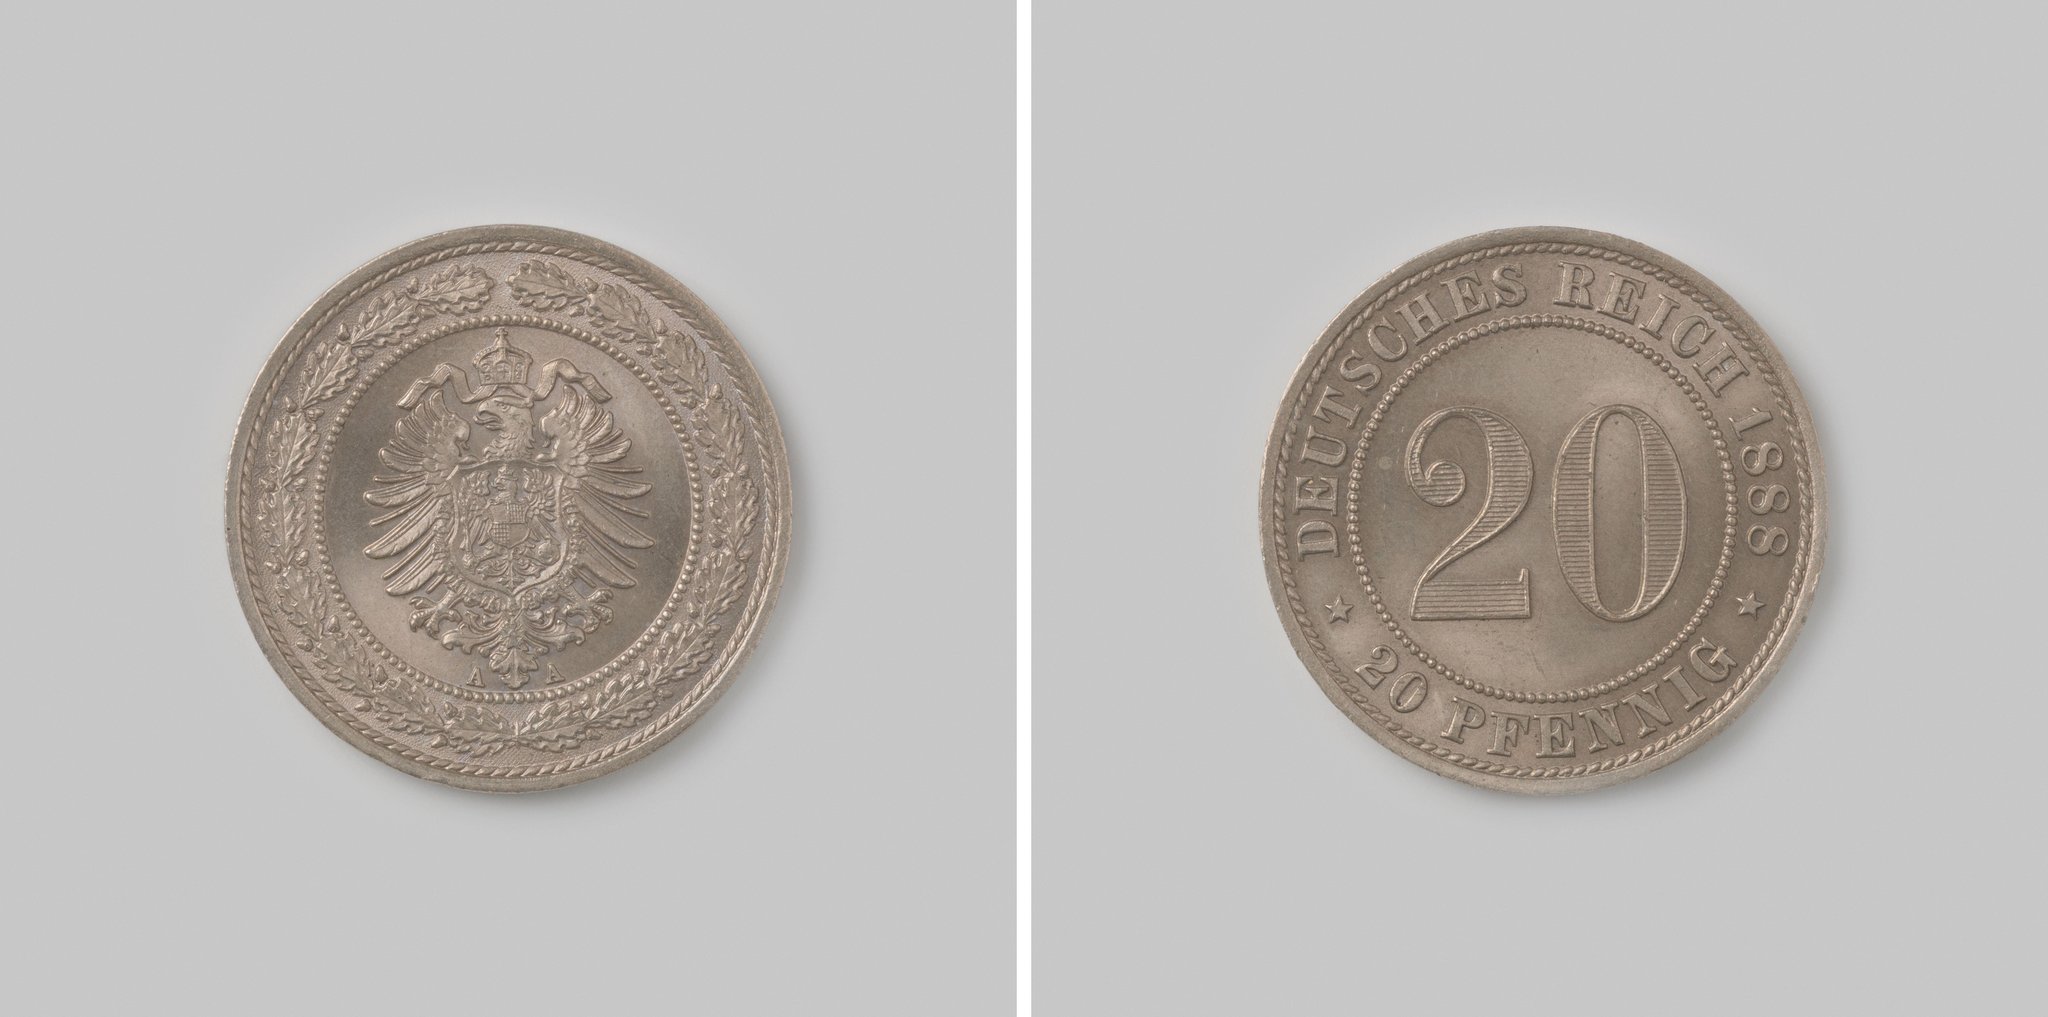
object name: twintig pfennig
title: Duitse Rijk, 20 pfennig,1888 A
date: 1888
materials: nickel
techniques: striking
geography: berlin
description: Nikkelen munt. Voorzijde: binnen krans van eikebladeren gekroonde enkelkoppige adelaar naar links met op borst door keten van orde met juweel omhangen samengesteld wapenschild. Daaronder twee letters A. Keerzijde: waarde-aanduiding in twee regels. Jaartal in omschrift. Gladde rand.